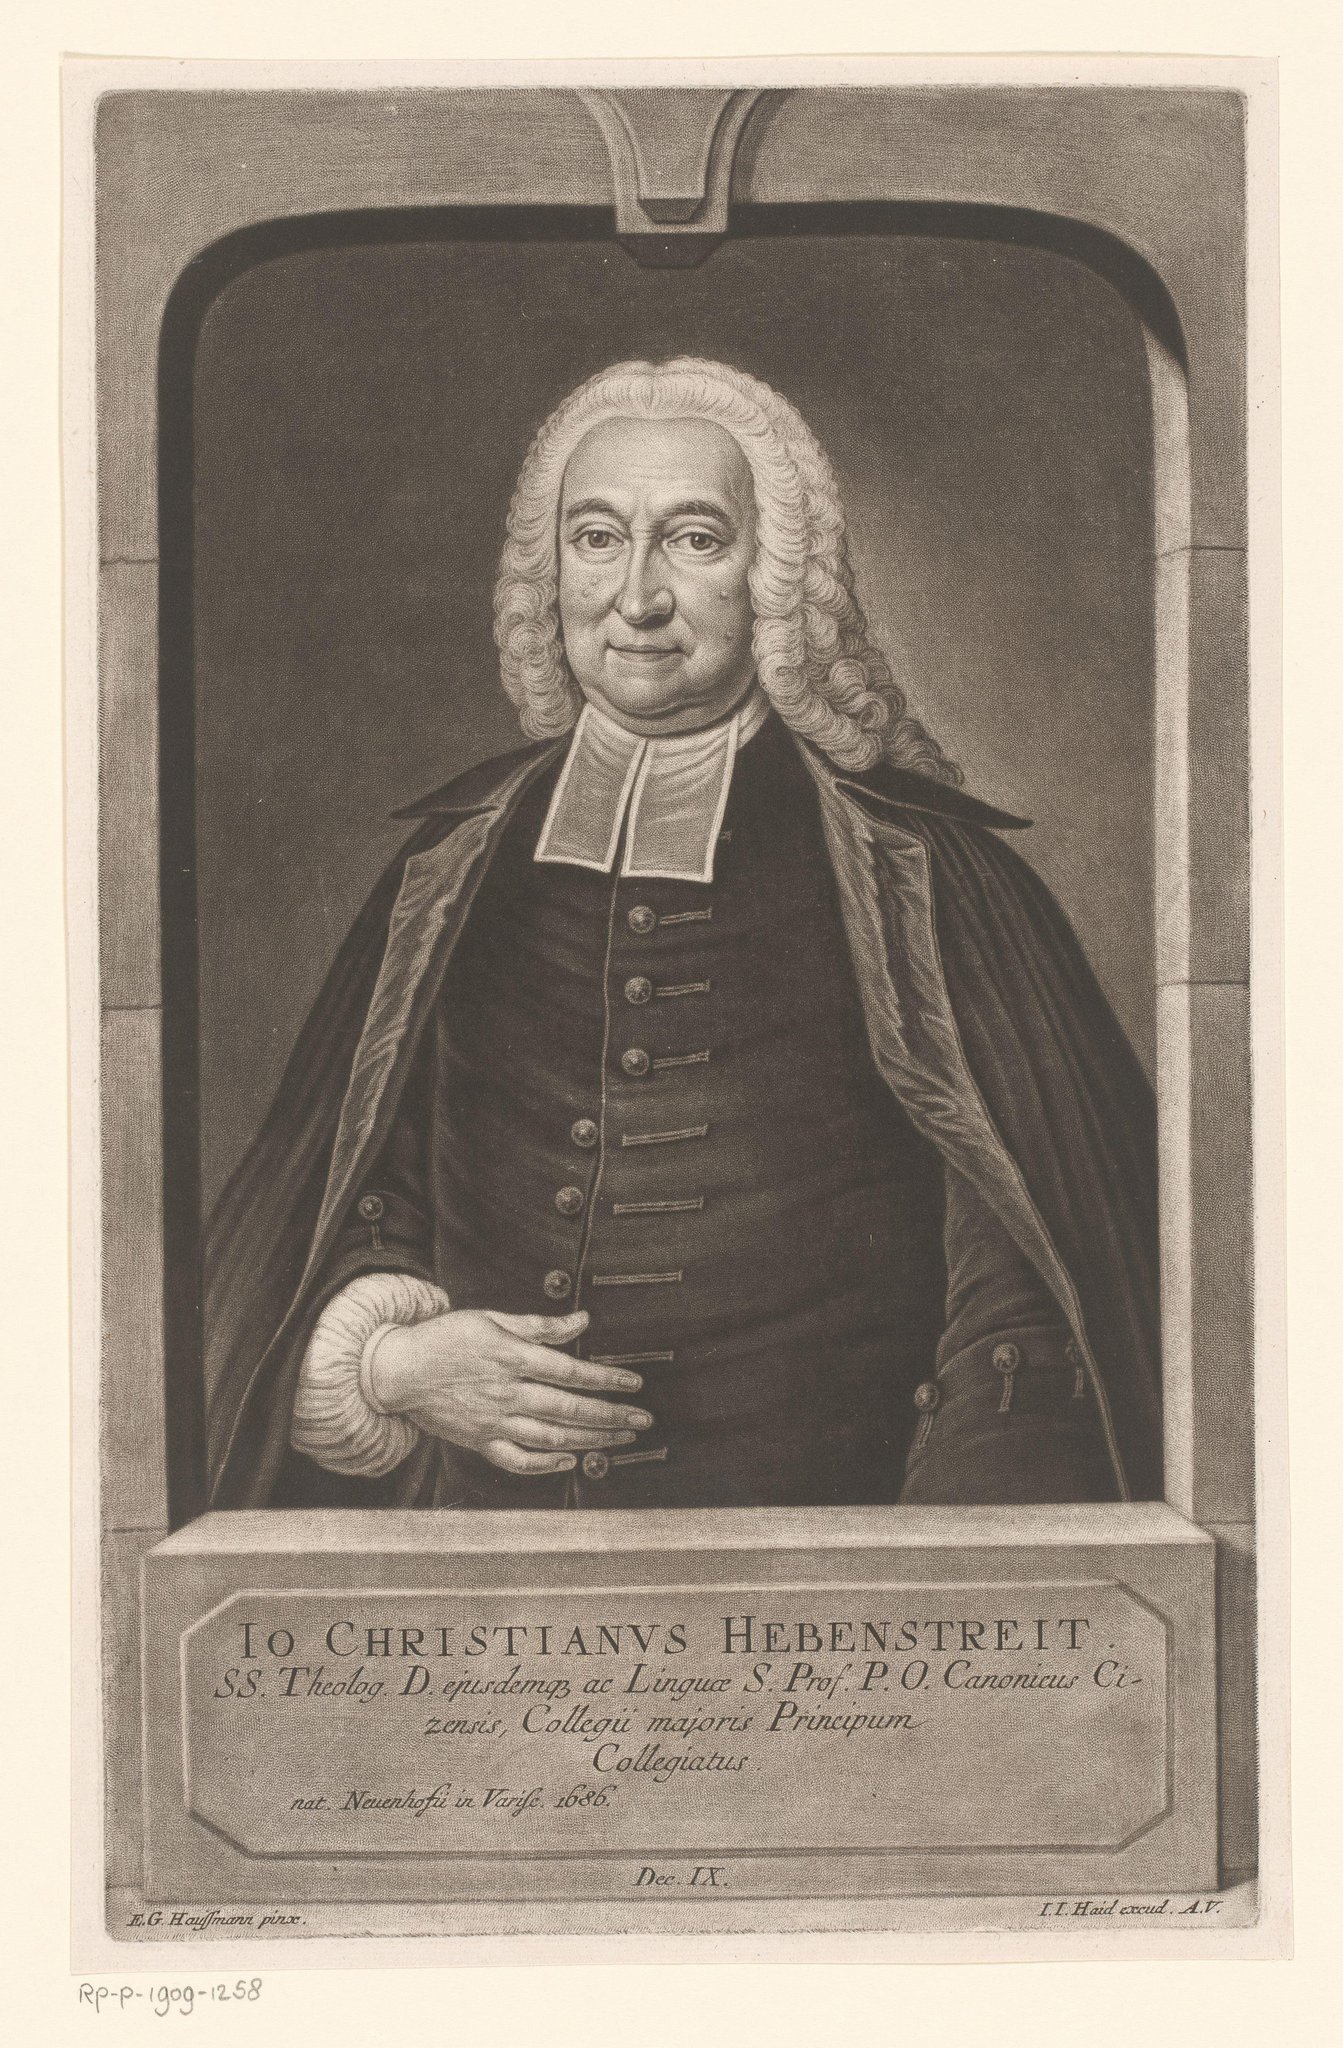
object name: print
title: Portret van Johann Christian Hebenstreit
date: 1752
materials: paper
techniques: mezzotint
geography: augsburg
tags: theologian, historical persons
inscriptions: collector's mark: Lugt 2228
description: Prent gebruikt voor: Brucker, Jacob. Bildersal heutiges Tages lebender und durch Gelahrtheit berühmter Schrifftsteller. Augsburg: Johann Jacob Haid, 1752.